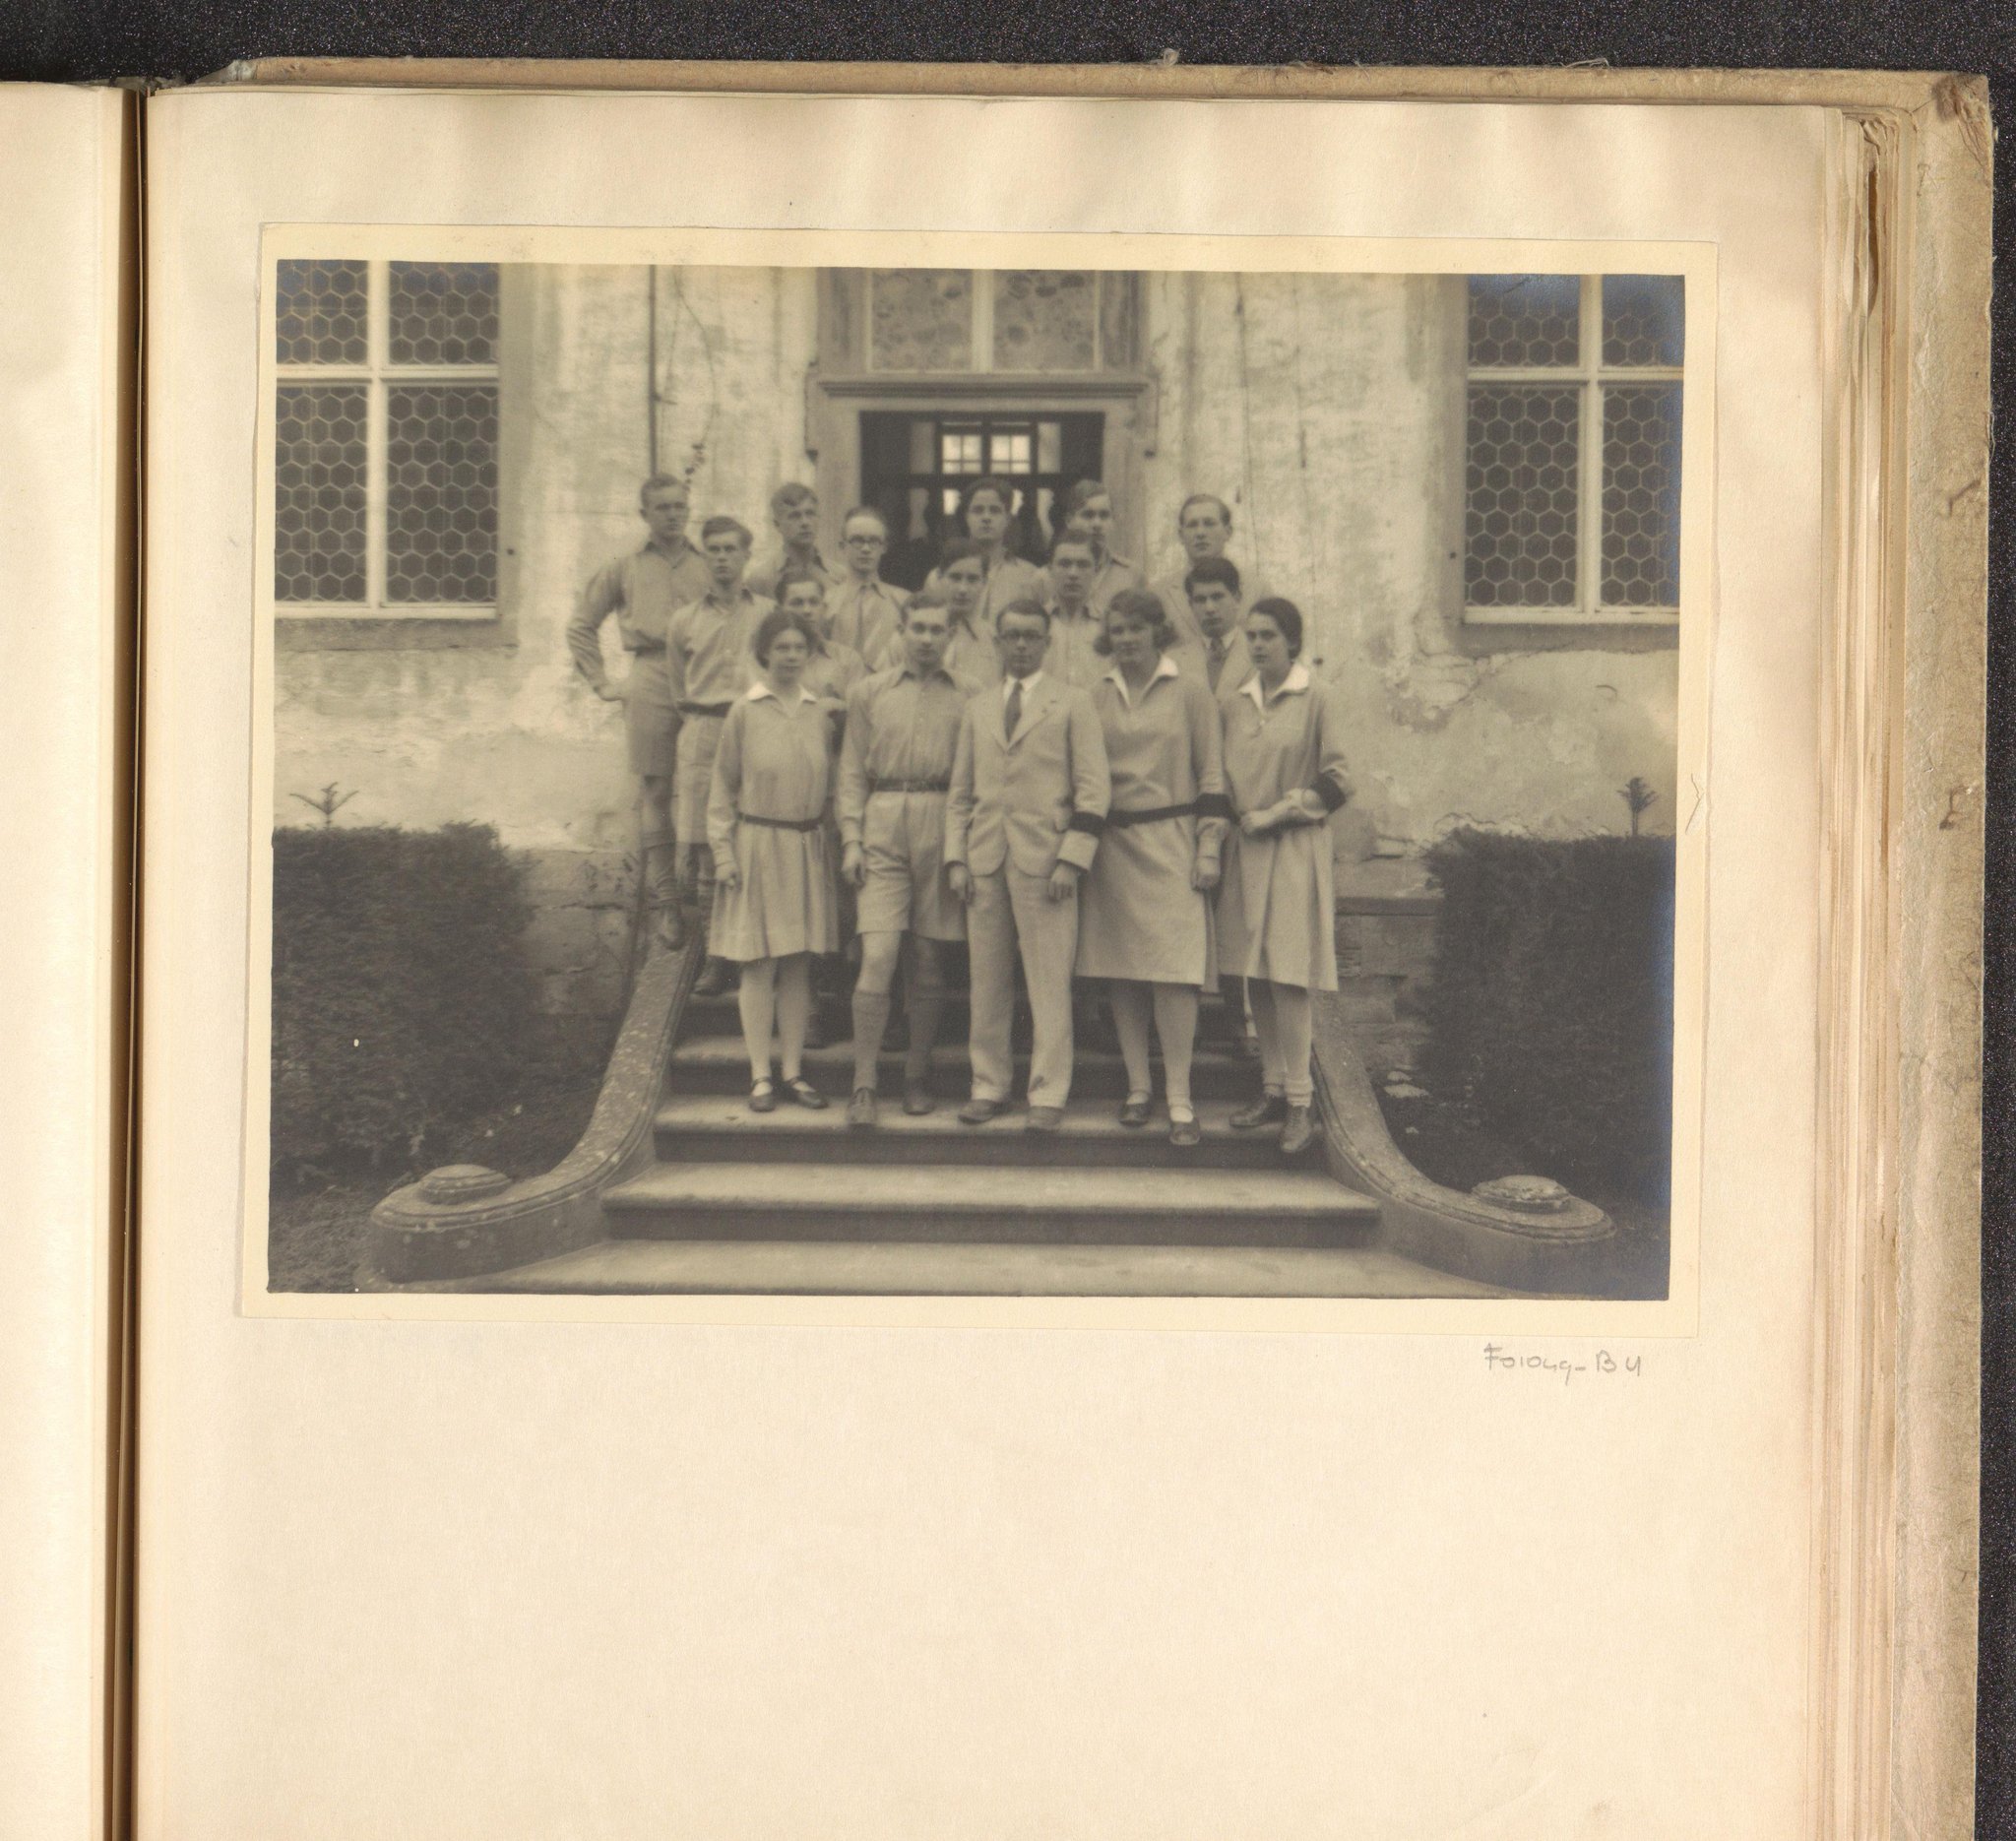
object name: photograph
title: Groepsportret van schoolhoofden van Schule Schloss Salem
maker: Anonymous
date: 1929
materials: photographic support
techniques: gelatin silver print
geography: salem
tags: student - bb - female student, education, student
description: Onderdeel van Fotoalbum van Schule Schloss Salem.